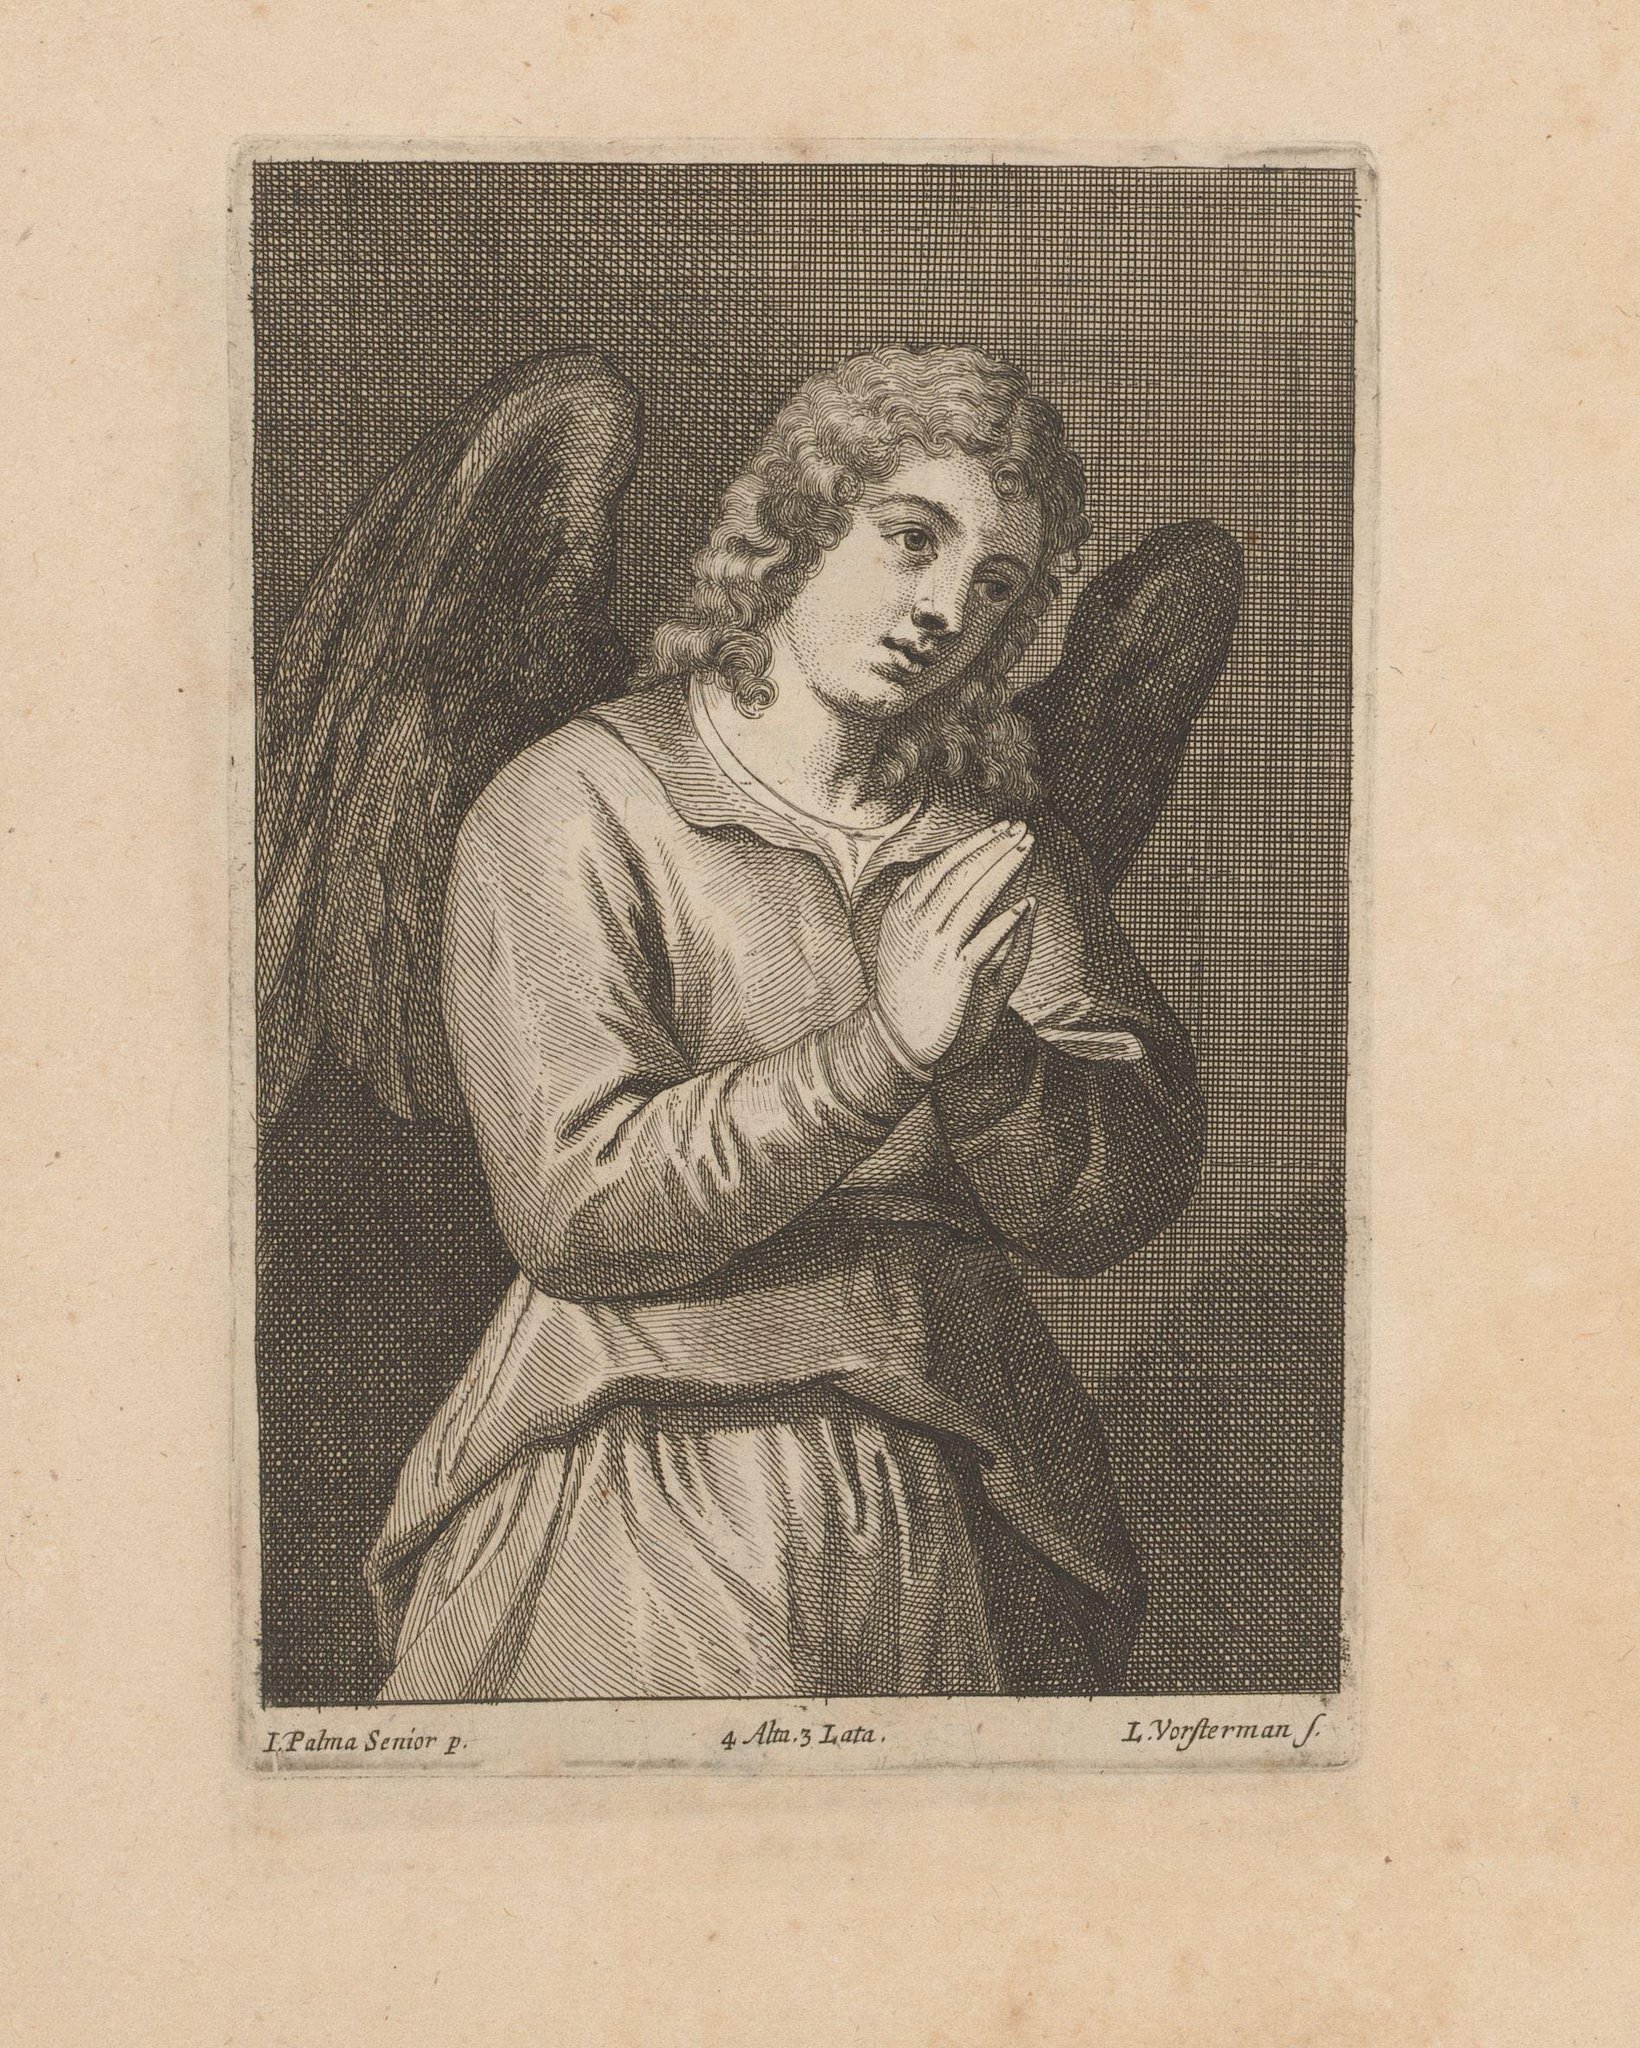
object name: print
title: Engel met gevouwen handen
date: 1660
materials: paper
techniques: etching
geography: antwerp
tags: angels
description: David Teniers heeft waarschijnlijk van alle schilderijen uit de collectie van Leopold Willem van Oostenrijk een olieverfstudie op doek of paneel vervaardigd (zgn. pasticcio), die als voorbeeld voor de prentmakers diende. Het is niet altijd duidelijk of de pasticci door hem zijn gemaakt of door zijn atelier. Niet alle pasticci zijn overgeleverd.